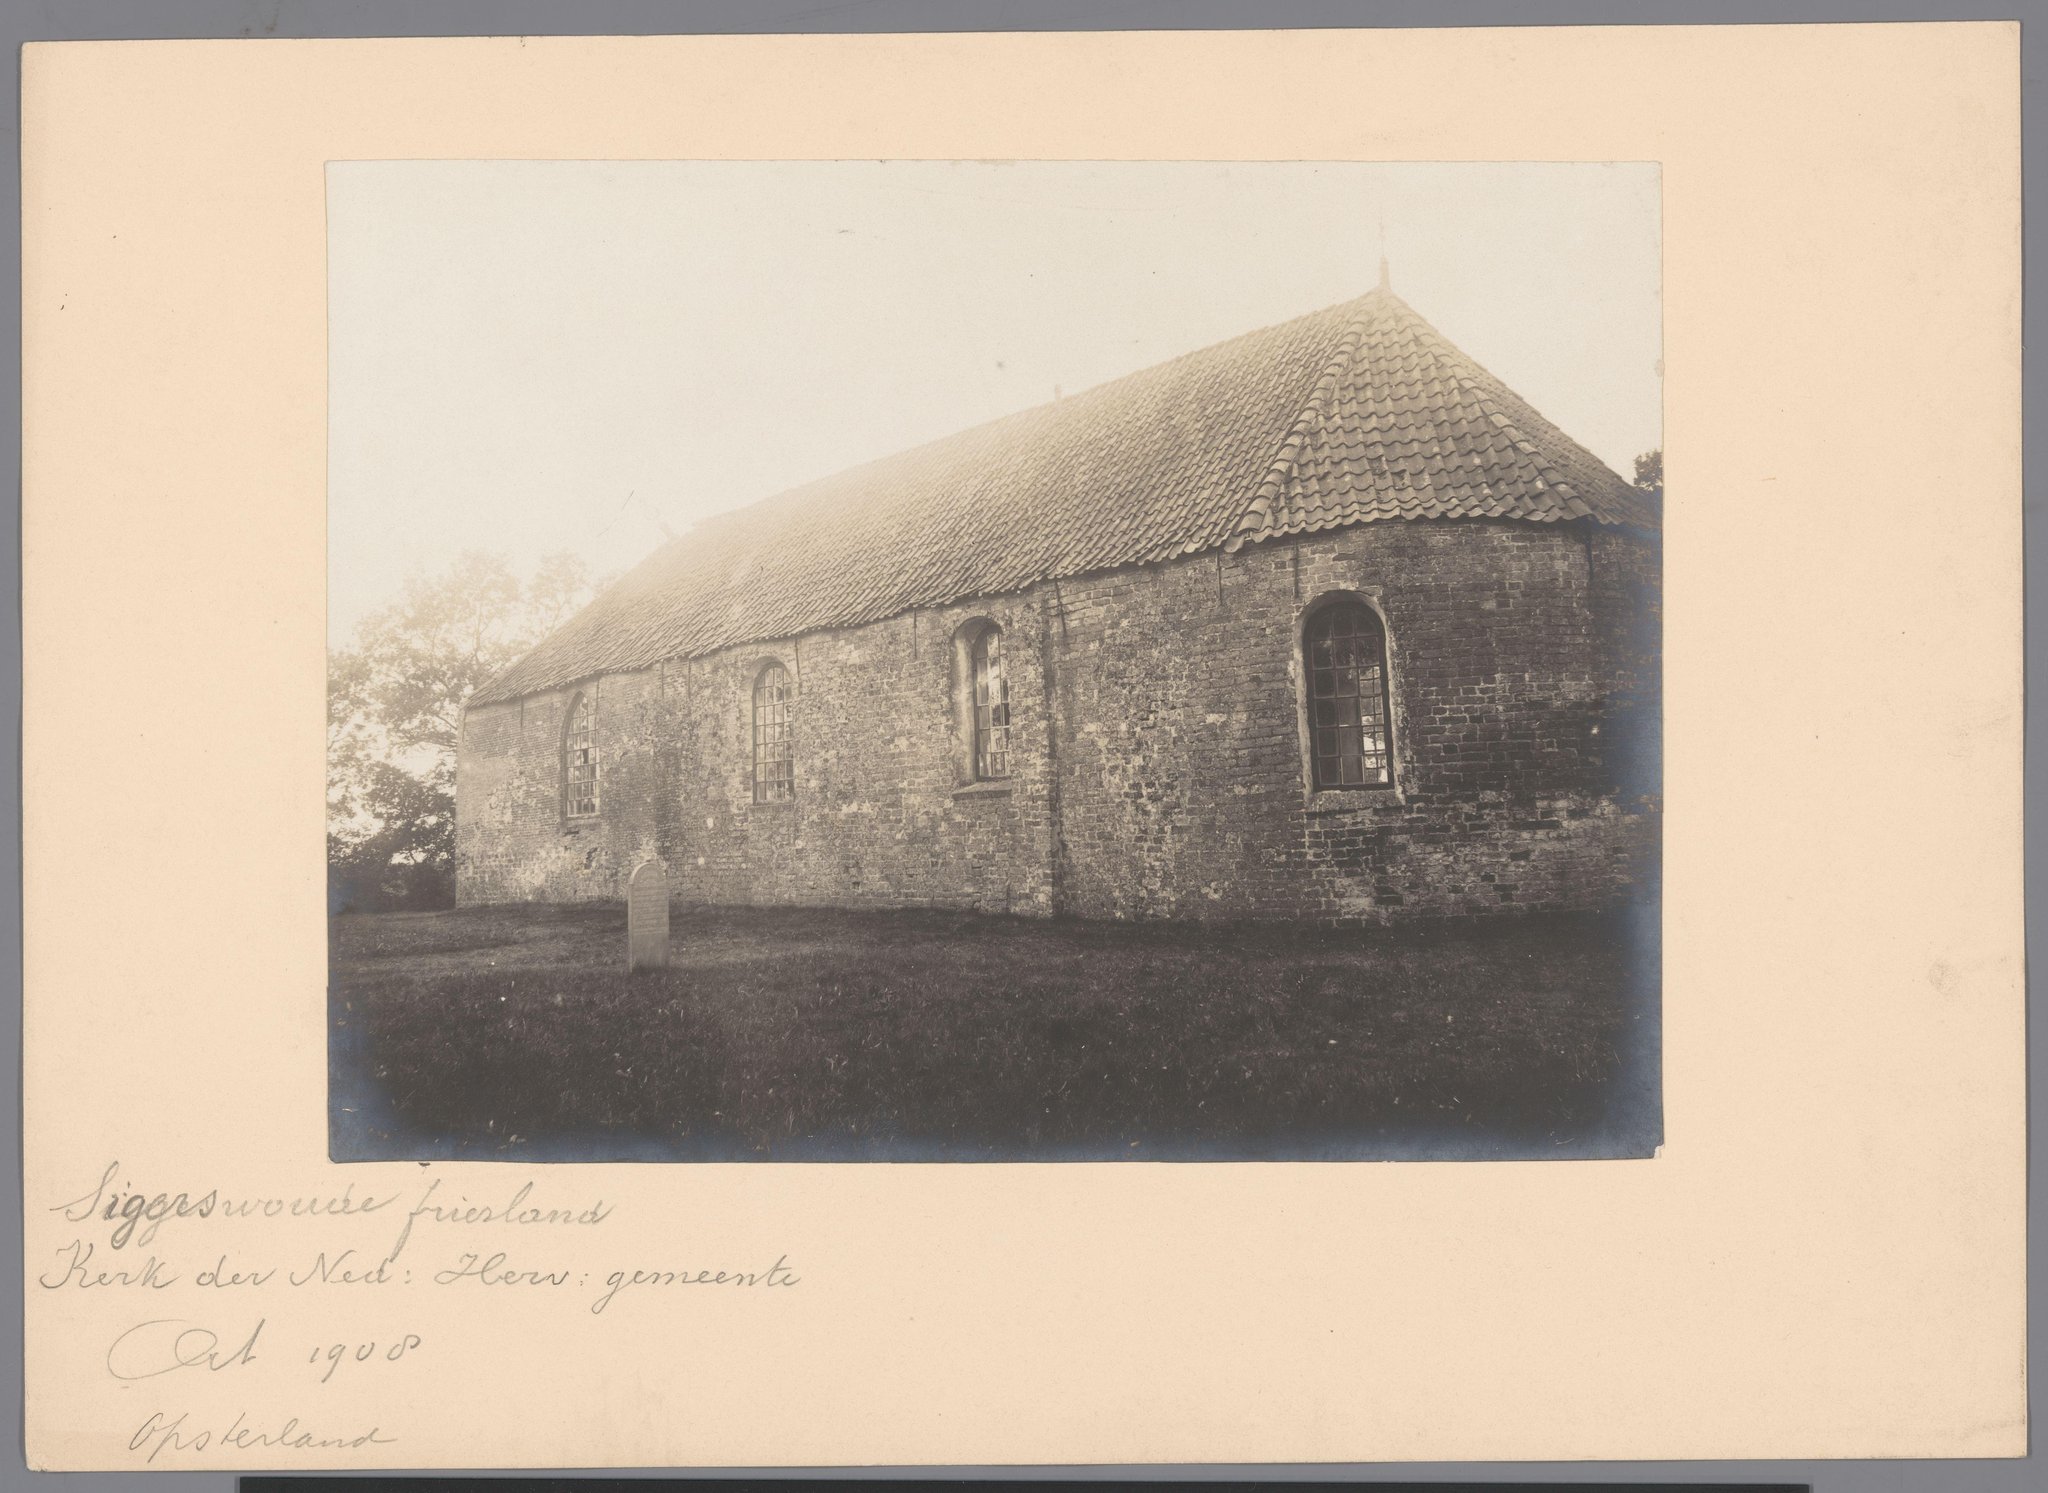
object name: photograph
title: Gezicht op de Hervormde Kerk te Siegerswoude, afgebroken in 1909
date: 1908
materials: cardboard, photographic support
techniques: gelatin silver print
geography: siegerswoude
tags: church (exterior)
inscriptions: annotation: ‘Siggerswoude / Interieur aanzicht / naar oost / Oct 1908/ Opsterland’